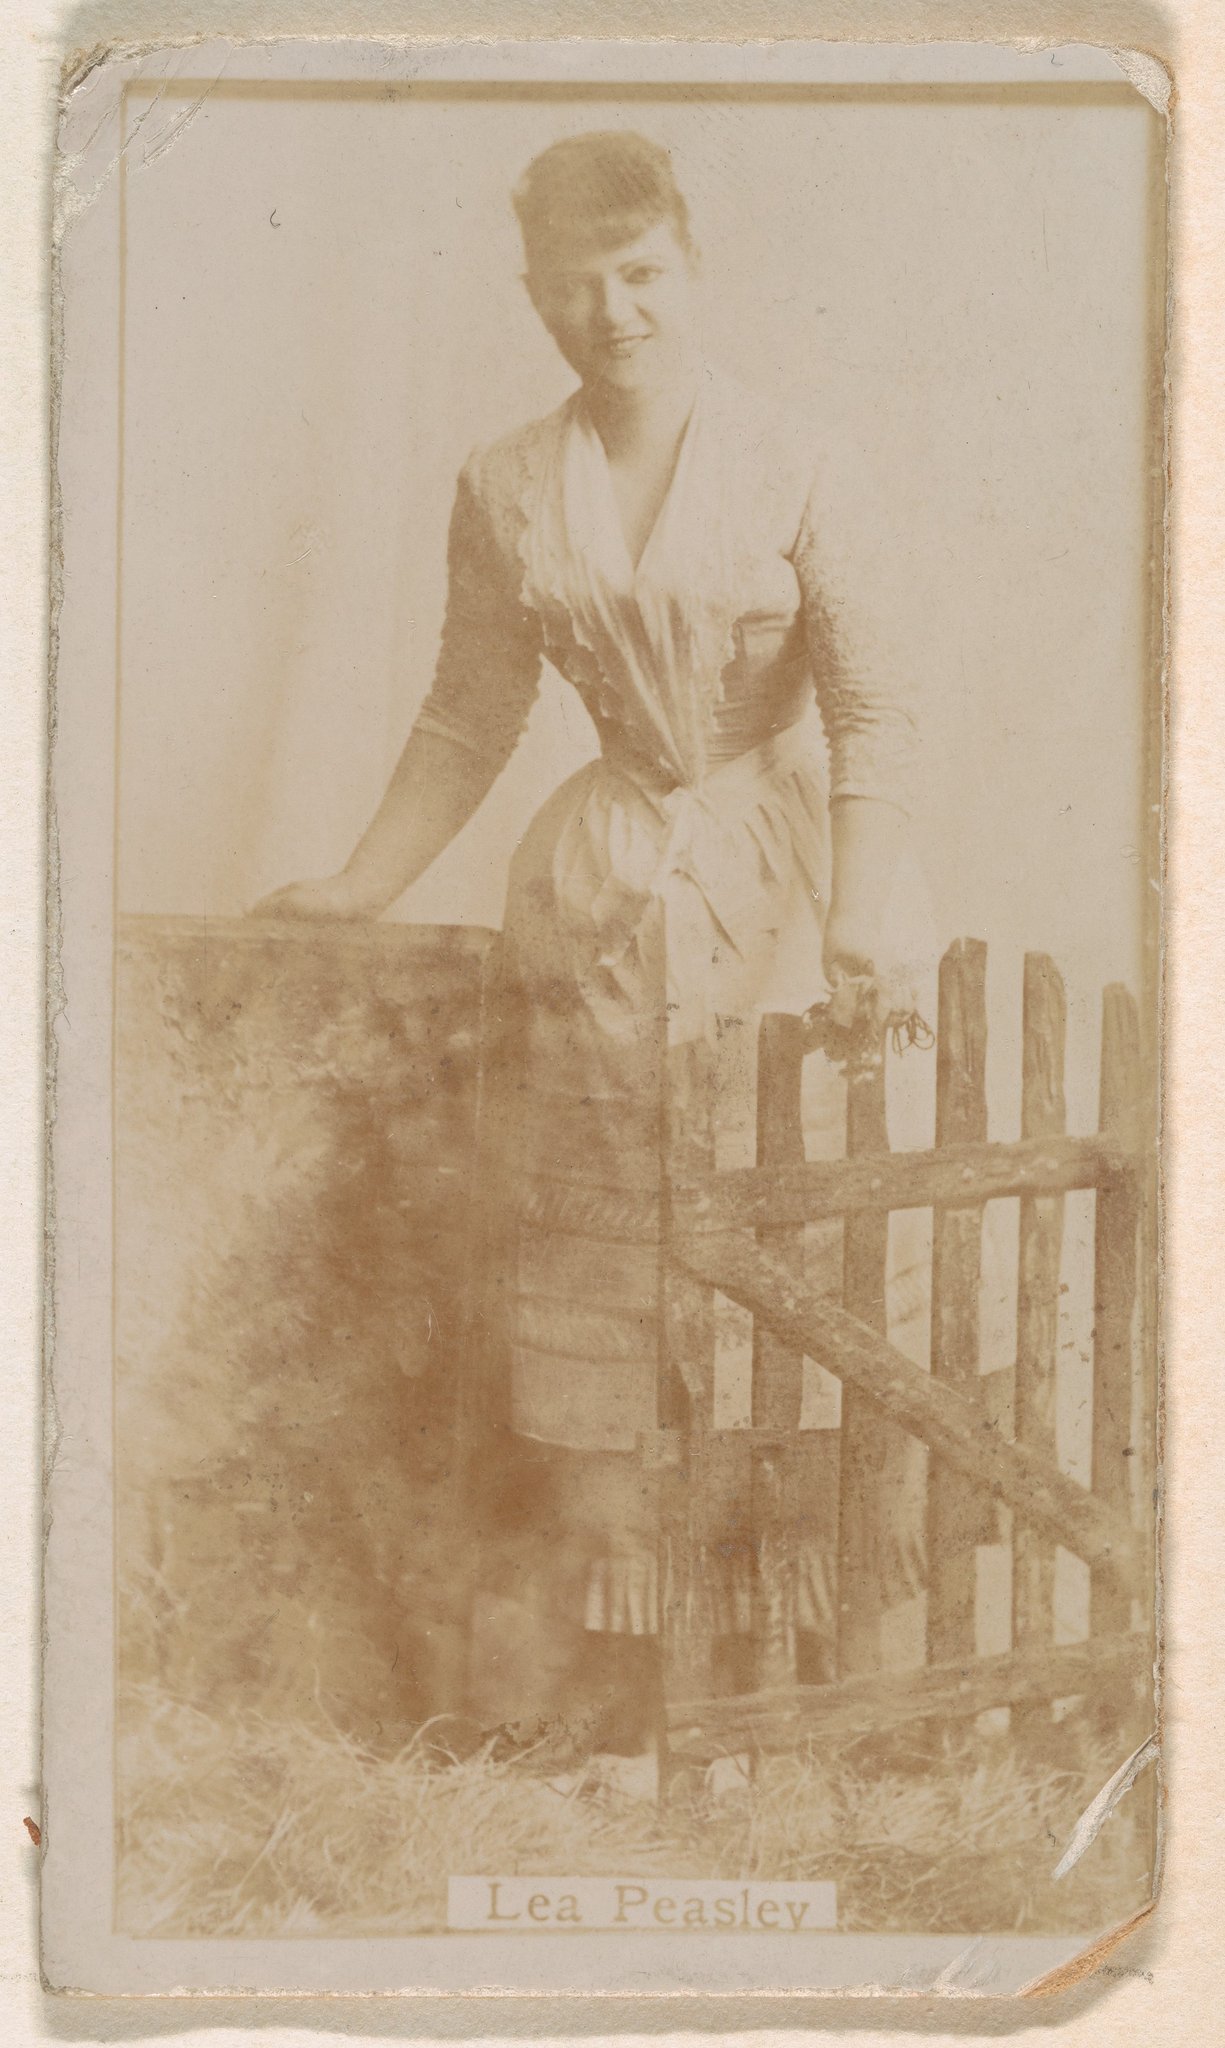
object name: photograph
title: Lea Peasley, from the Actresses series (N245) issued by Kinney Brothers to promote Sweet Caporal Cigarettes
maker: kinney brothers tobacco company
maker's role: publisher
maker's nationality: american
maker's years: 1869-2011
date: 1890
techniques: albumen silver print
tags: portraits,women,actresses